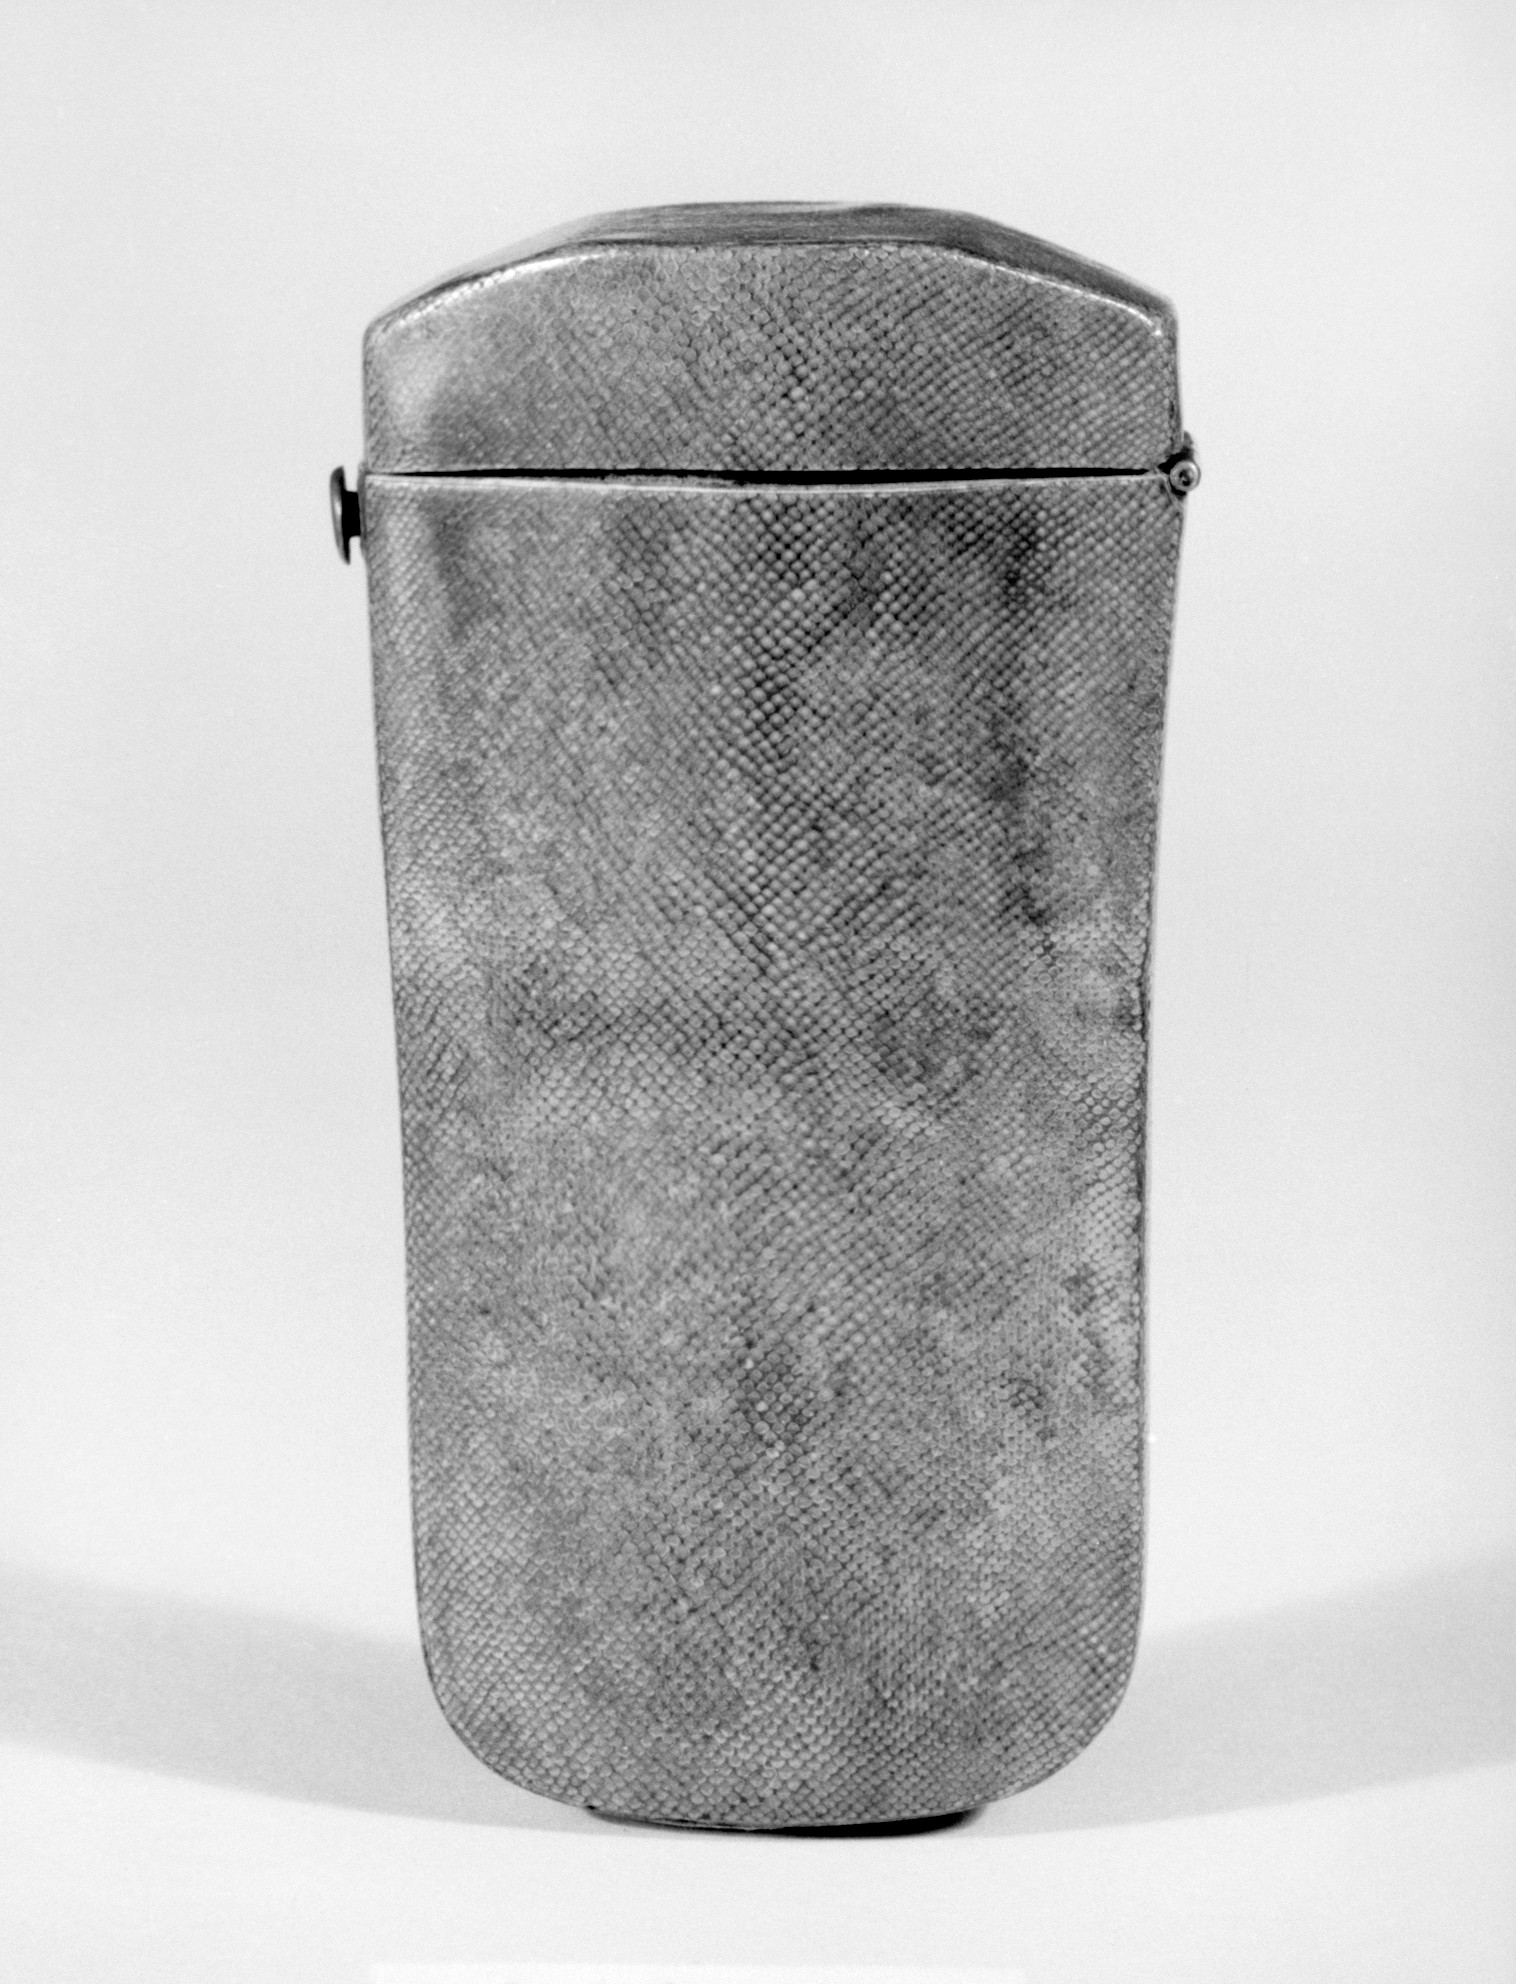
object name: box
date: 1701-1800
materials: brass, wood